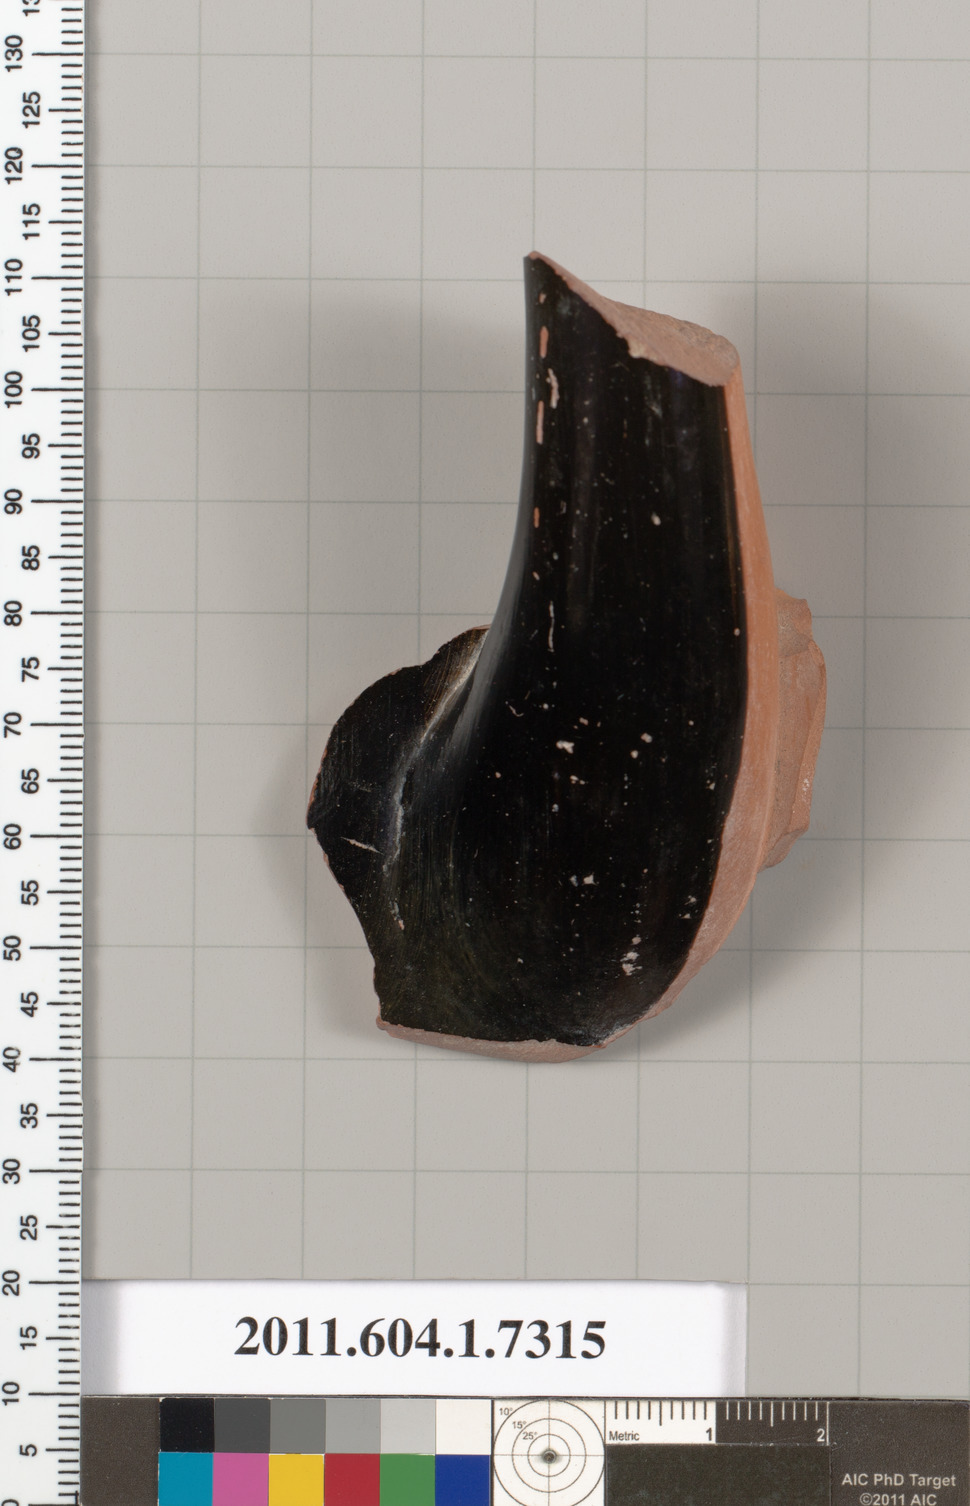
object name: kylix fragment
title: Terracotta fragment of a kylix (drinking cup)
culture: greek, attic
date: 500-480 BCE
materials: terracotta